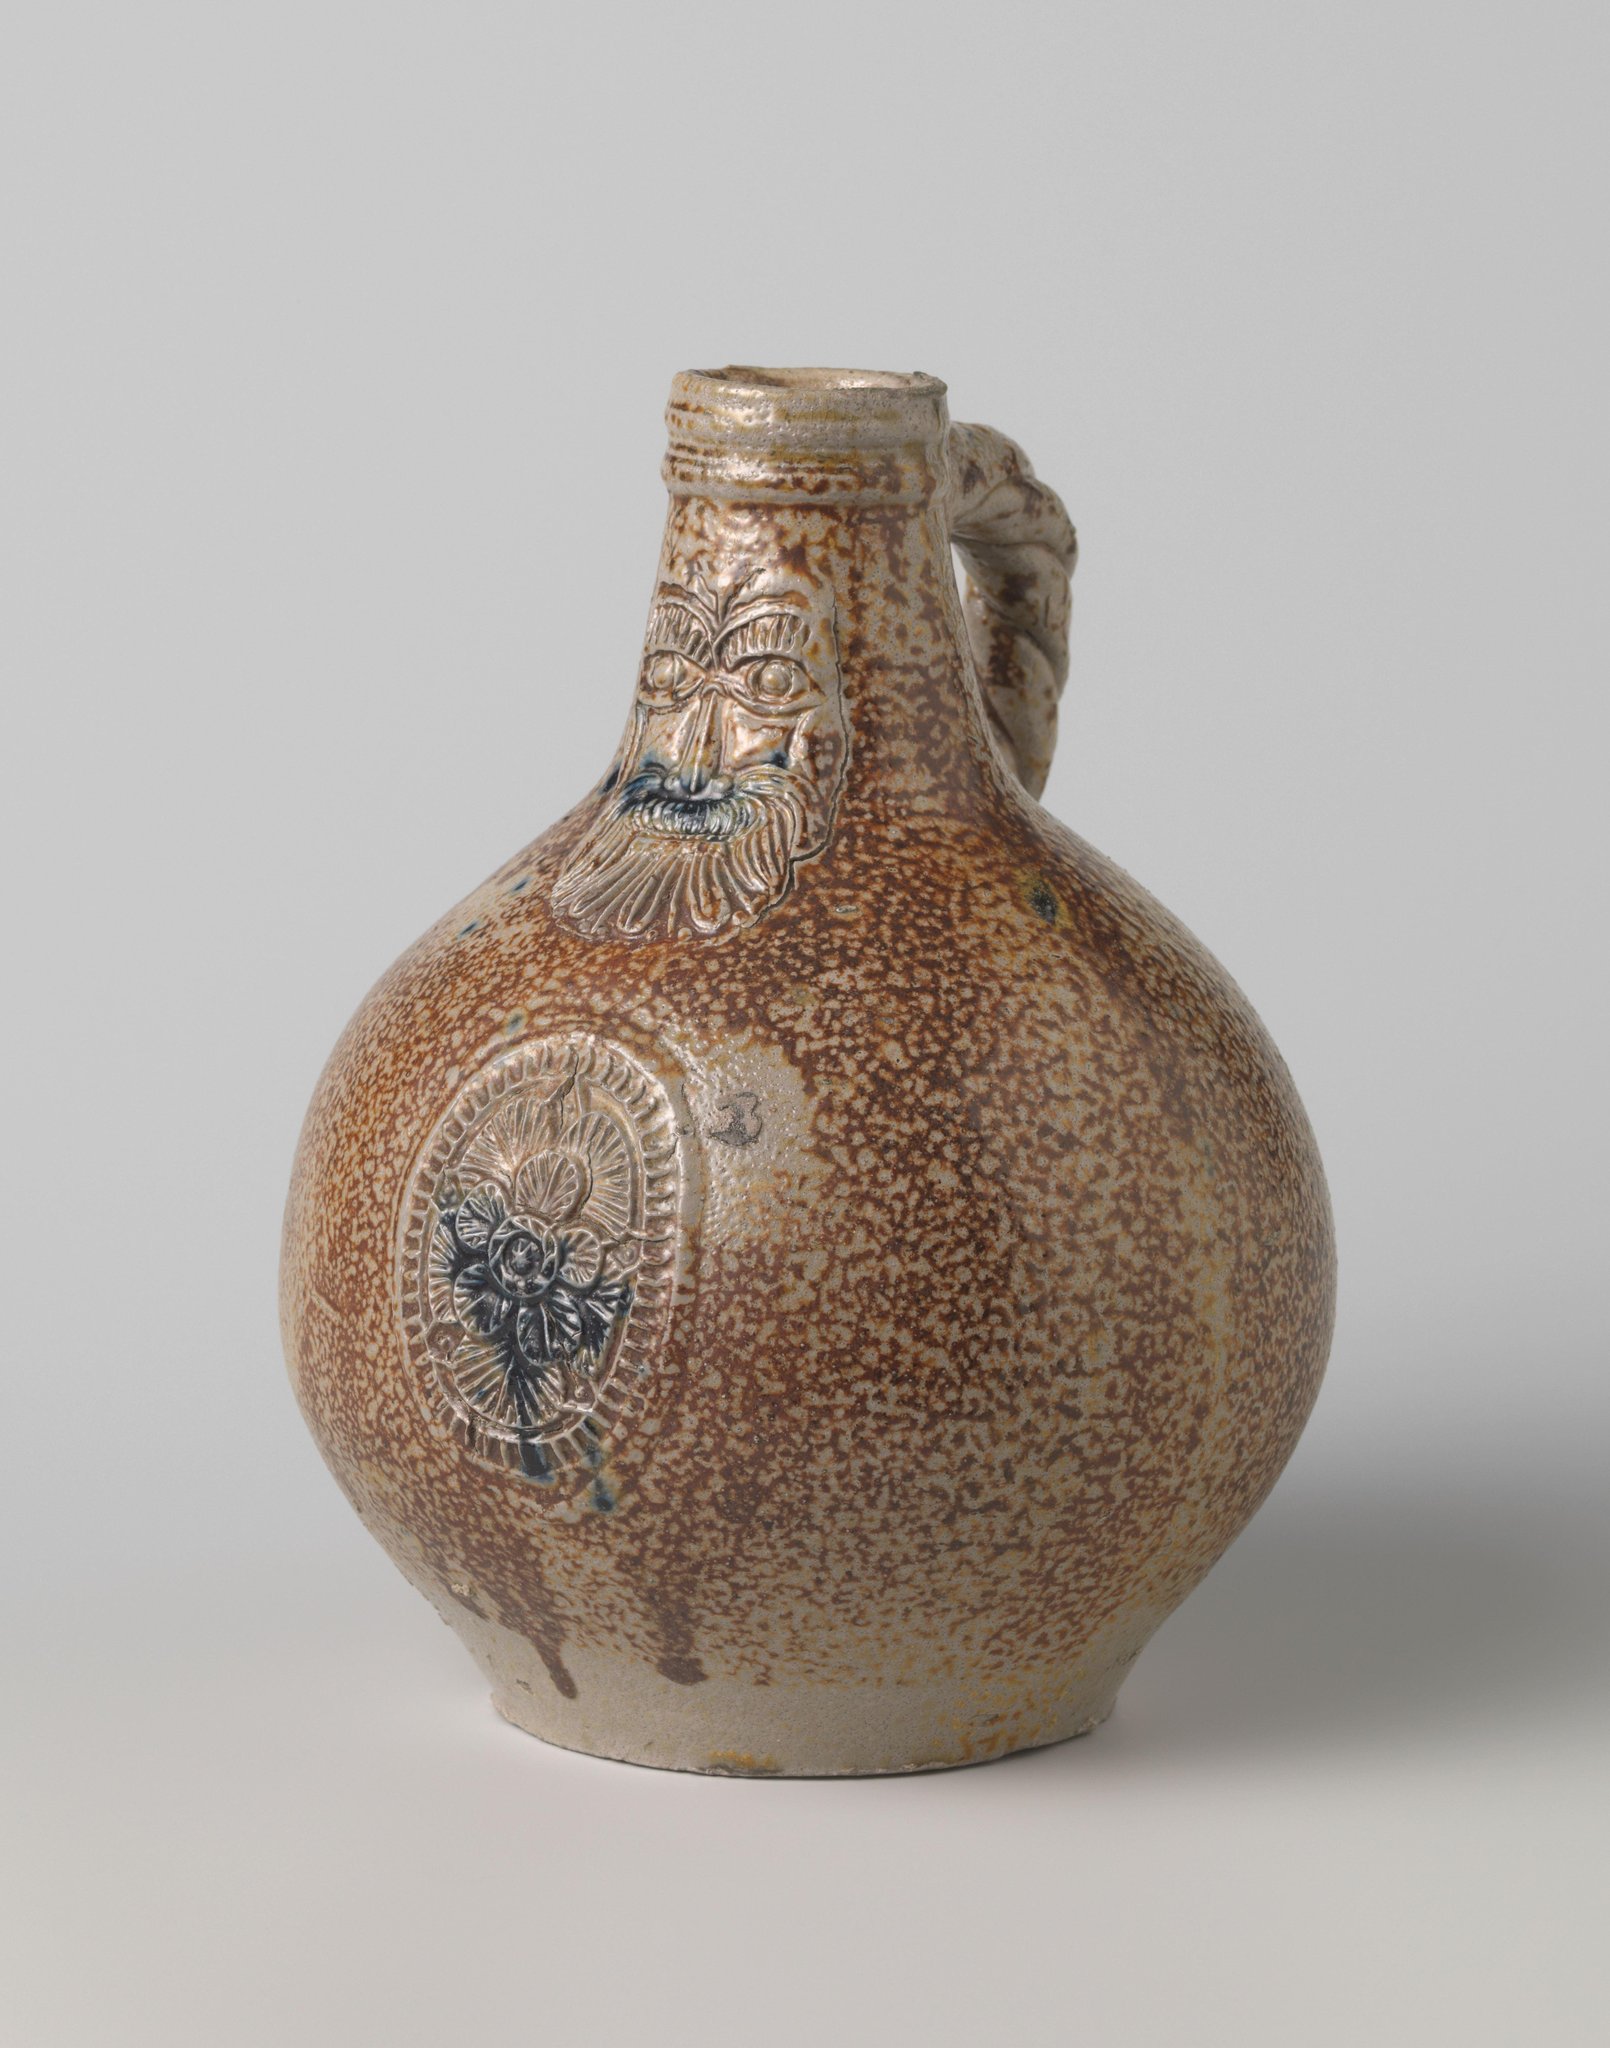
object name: bellarmine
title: Jug (Bartmann jug) with a flower in a medallion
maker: Anonymous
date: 1600-1649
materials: cobalt, glaze, stoneware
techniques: firing, forming, relief, turning, vitrification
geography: frechen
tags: enkhuizen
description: Kruik (baardmankruik) van steengoed op standvlak met een bolvormig lichaam en smalle nek. Het getordeerde, C-vormige oor is bevestigd aan de nek en de schouder. Profielen op de nek. Bedekt met een bruin gevlekt glazuur en kobaltblauw. Op de buik in reliëf een gedrukt en opgelegd medaillon met een bloem. Op de nek, doorlopend op de schouder, een baardman. Frechen.